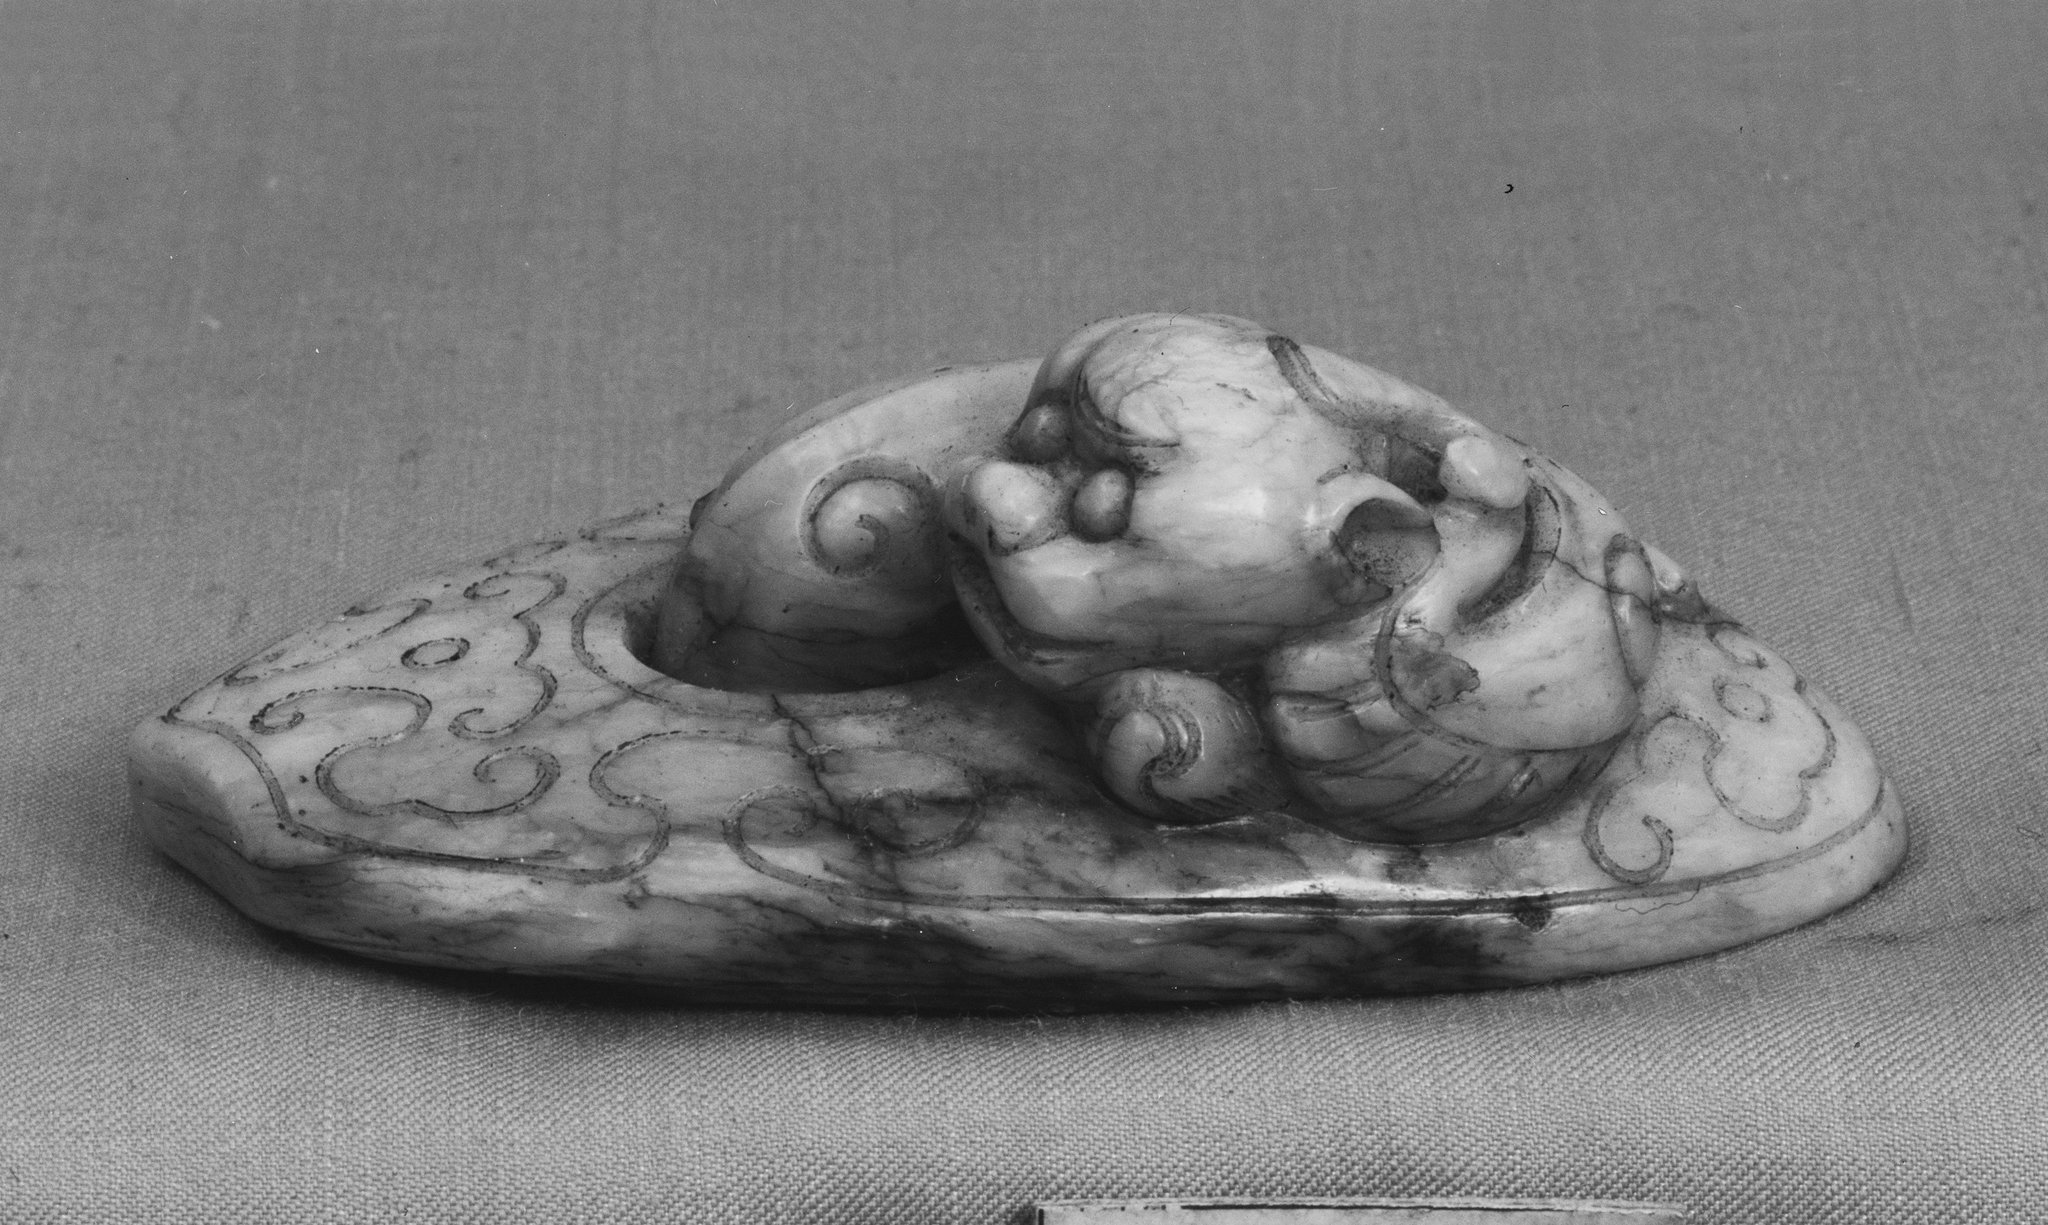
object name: disk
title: Disk with dragon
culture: chinese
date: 1644-1911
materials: jade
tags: mythical creatures